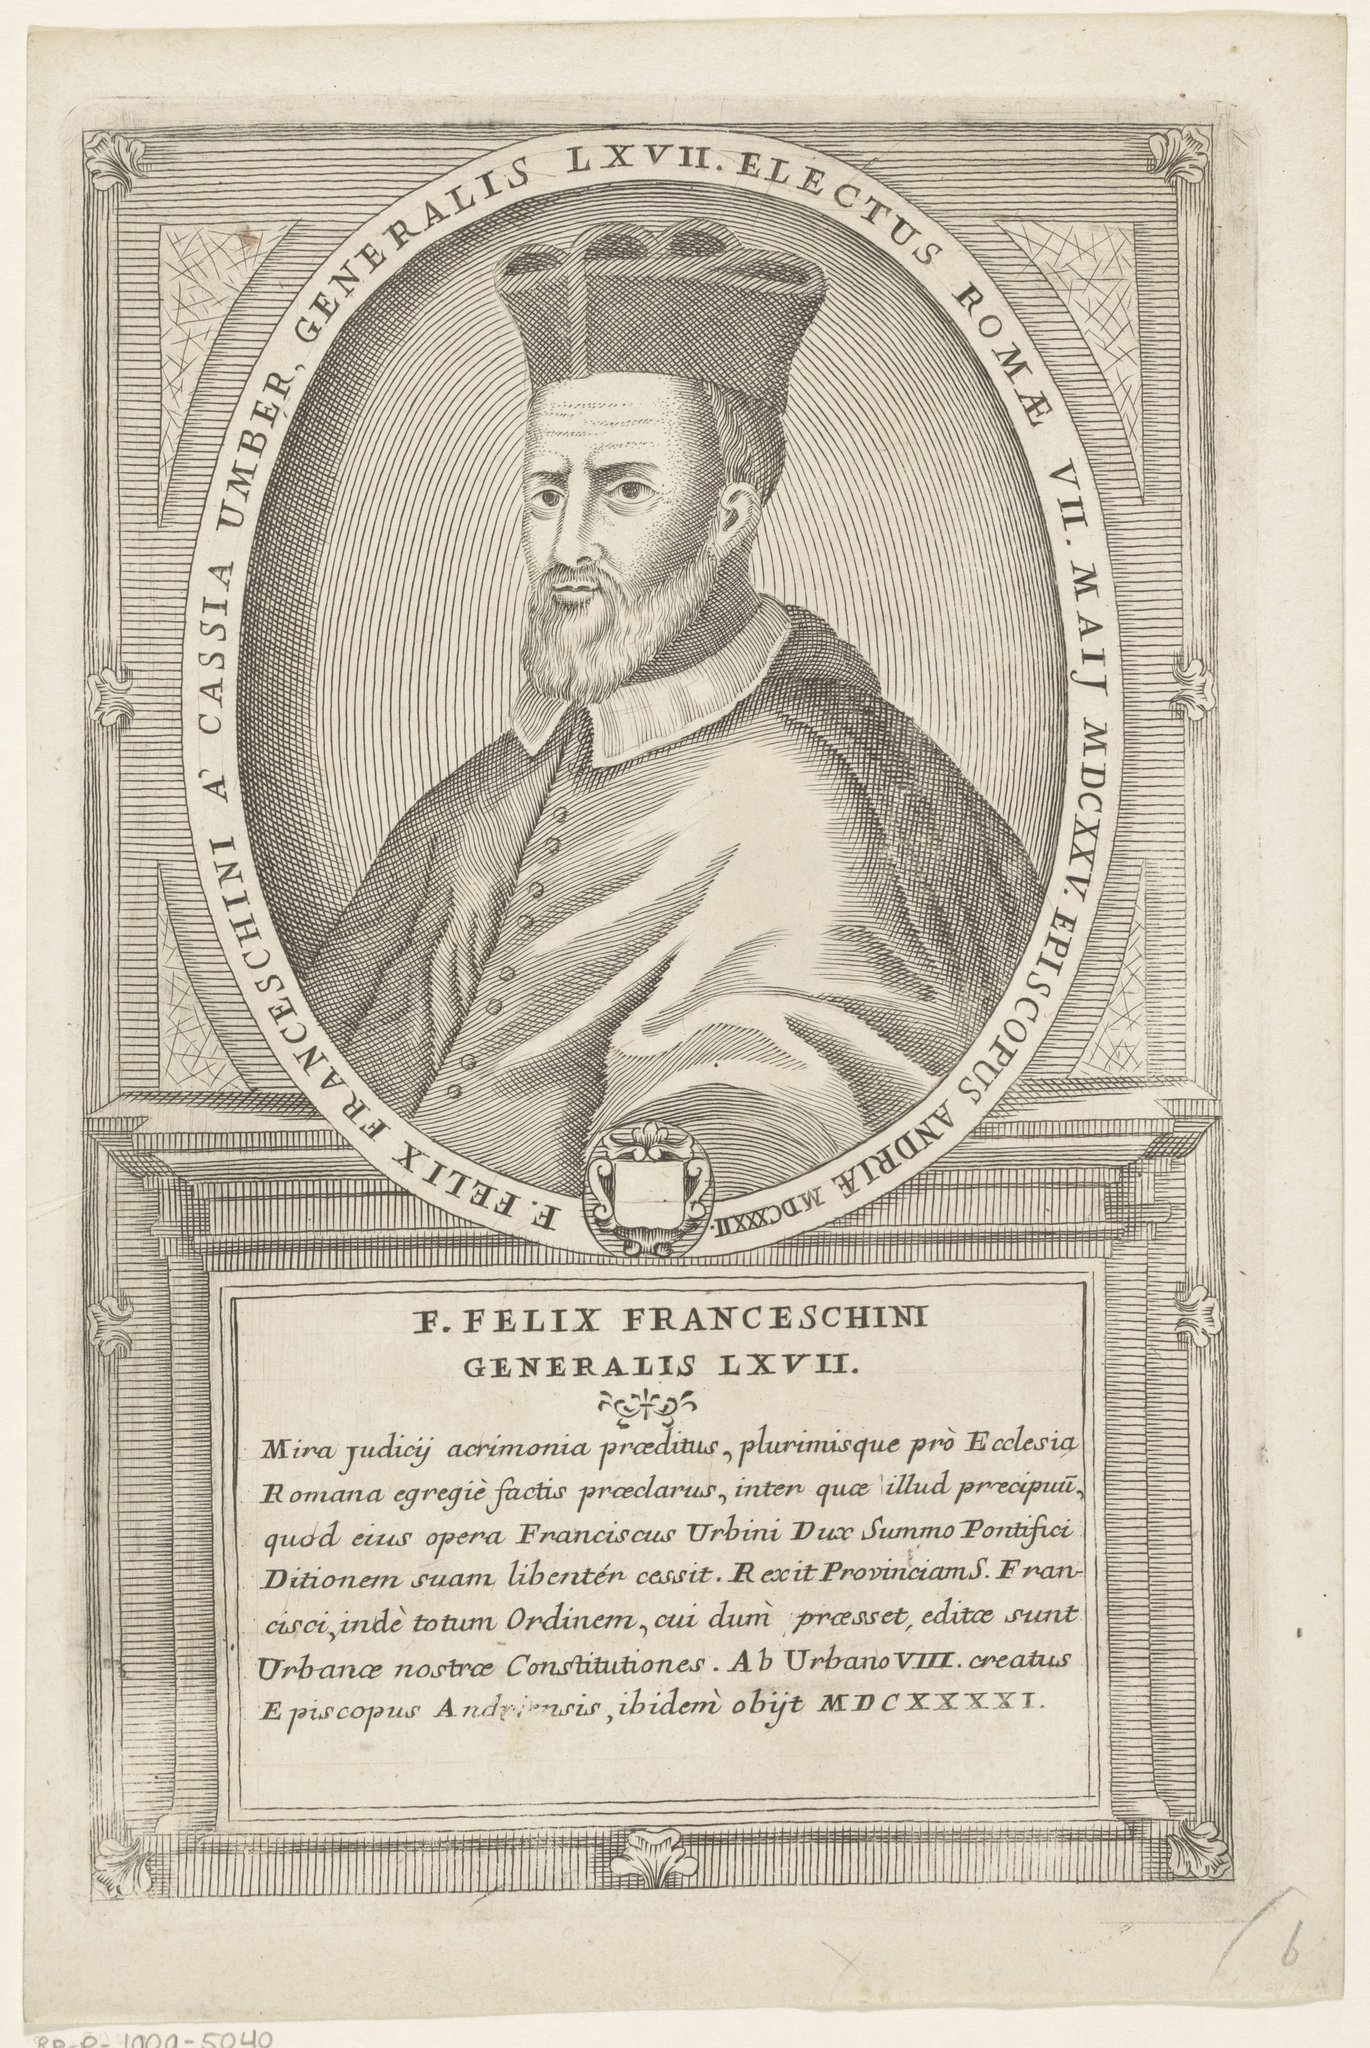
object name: print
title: Portretten van Ministers Generaal van de franciscaner orde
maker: antonio luciani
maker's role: print maker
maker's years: 1700-1738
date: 1710-1738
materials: paper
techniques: engraving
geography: italy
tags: historical persons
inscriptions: collector's mark: Lugt 2228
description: Deze prent maakt deel uit van een groep van 60 portretten.